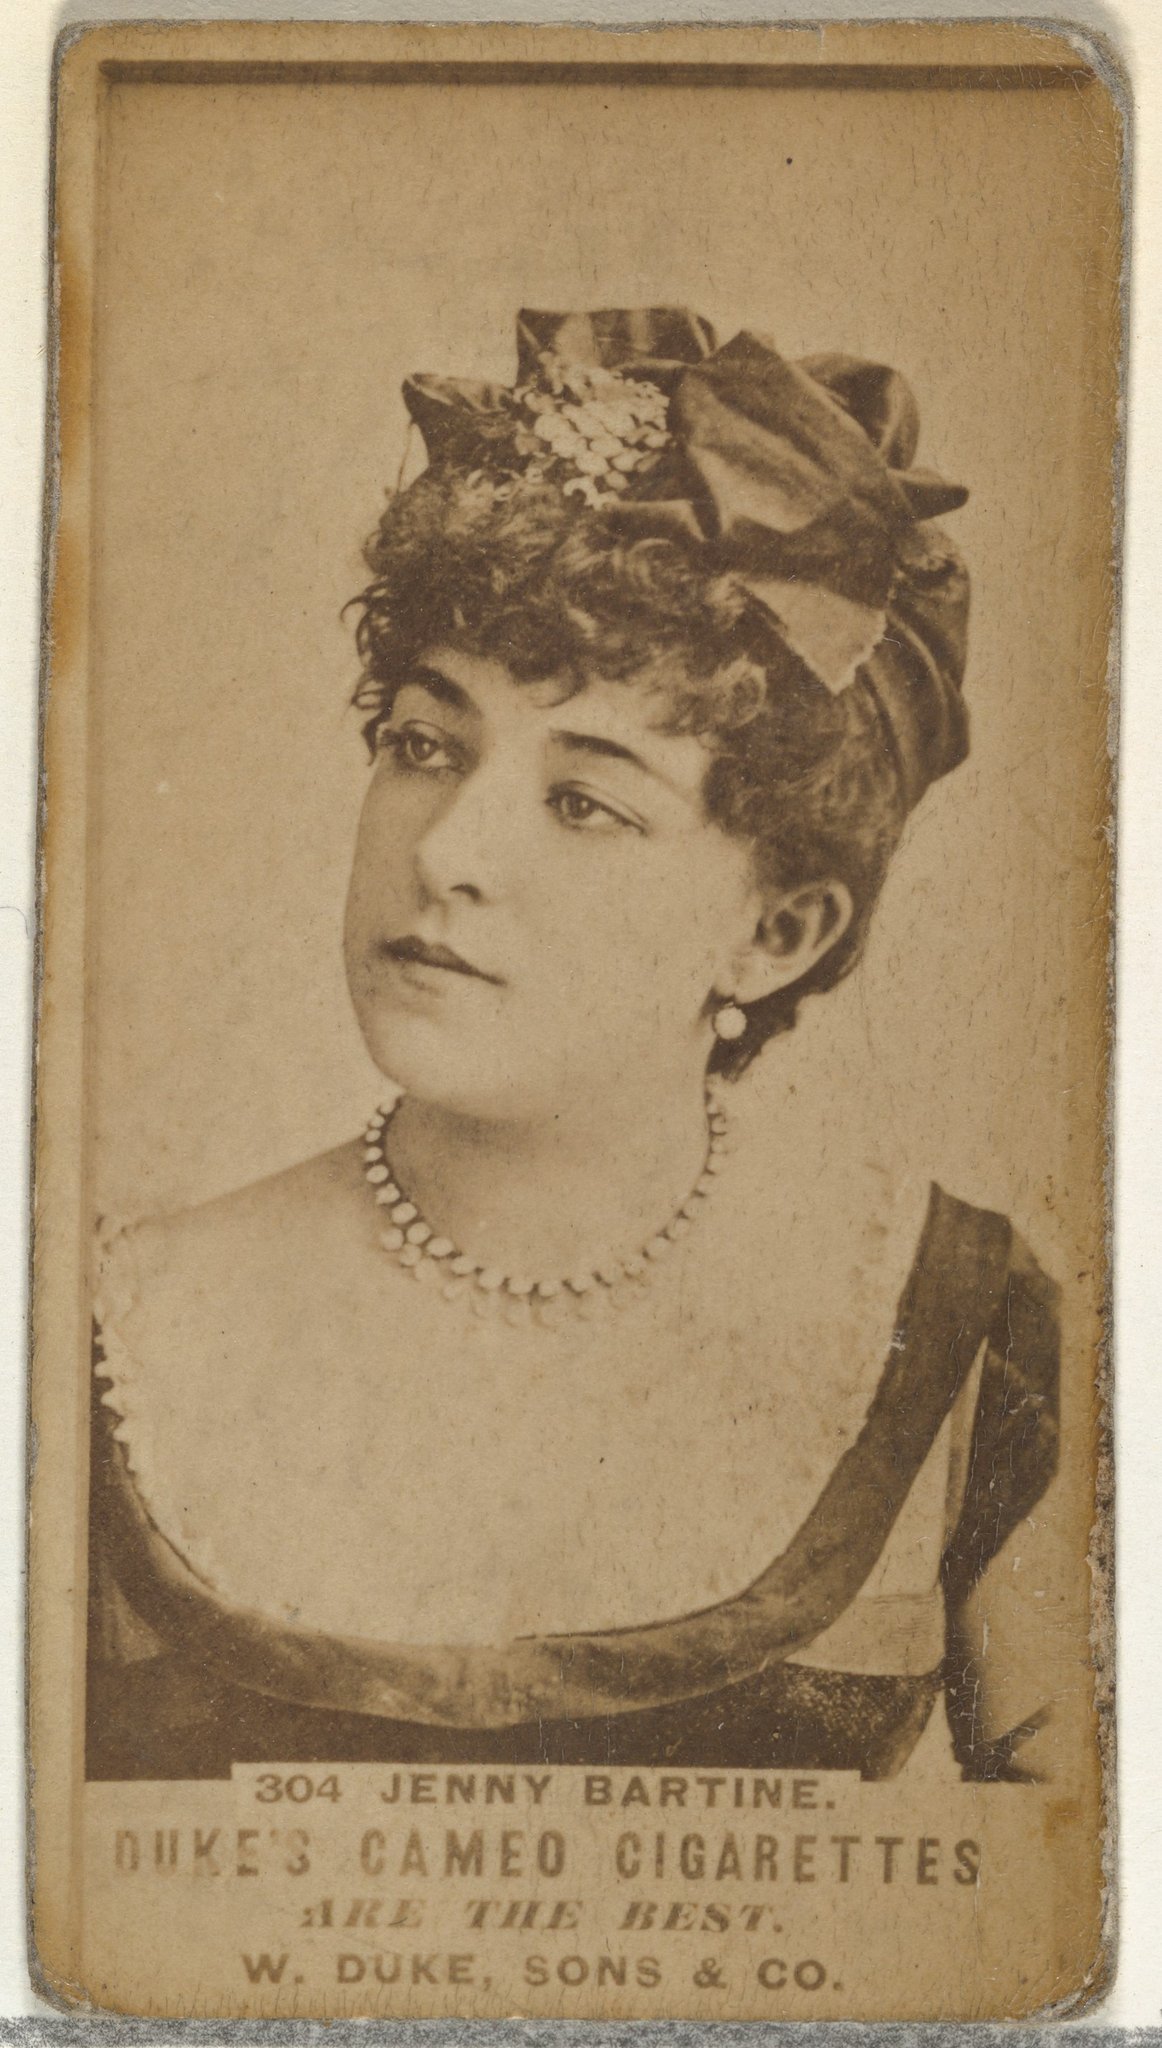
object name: photograph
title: Card Number 304, Jenny Bartine, from the Actors and Actresses series (N145-5) issued by Duke Sons & Co. to promote Cameo Cigarettes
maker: w. duke, sons & co.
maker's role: publisher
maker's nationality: american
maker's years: 1870-1920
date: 1880-1889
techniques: albumen silver print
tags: portraits,women,actresses